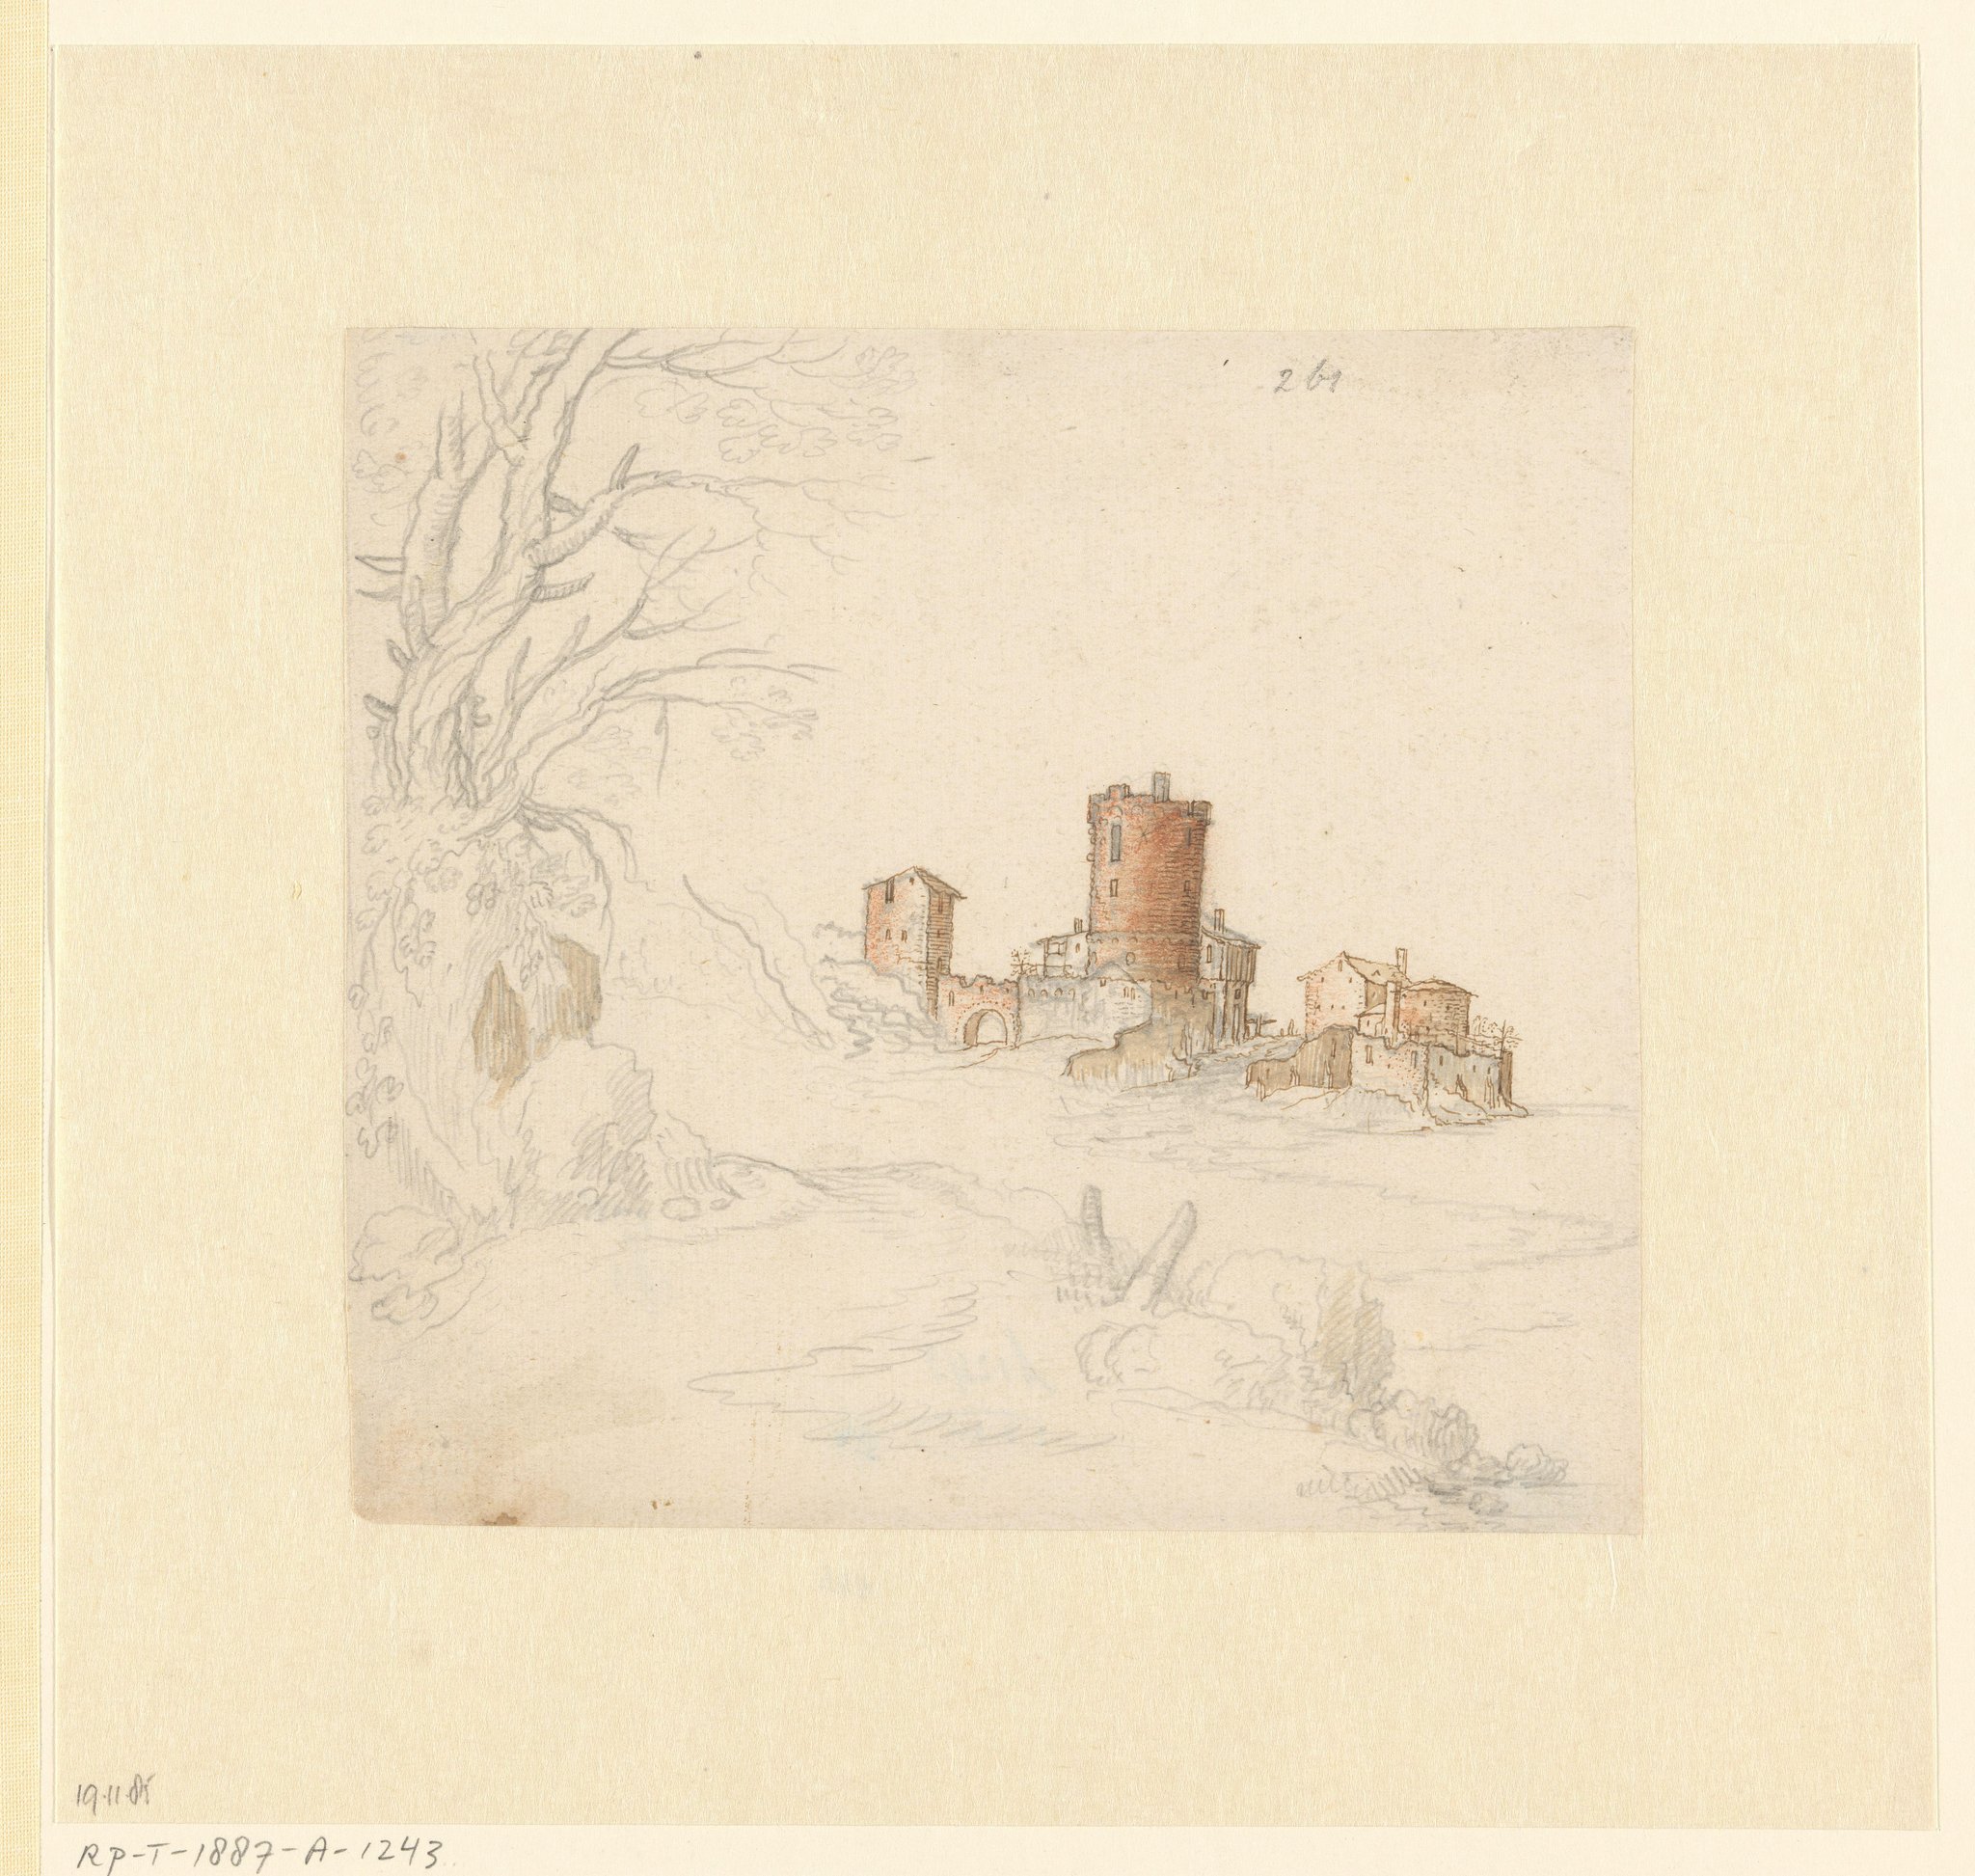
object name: drawing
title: Landschap met gebouwen en een toren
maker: gerard van der horst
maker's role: draughtsman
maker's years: 1581-1629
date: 1610-1628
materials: chalk, ink, paper, pencil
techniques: brush, pen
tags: landscape with tower or castle